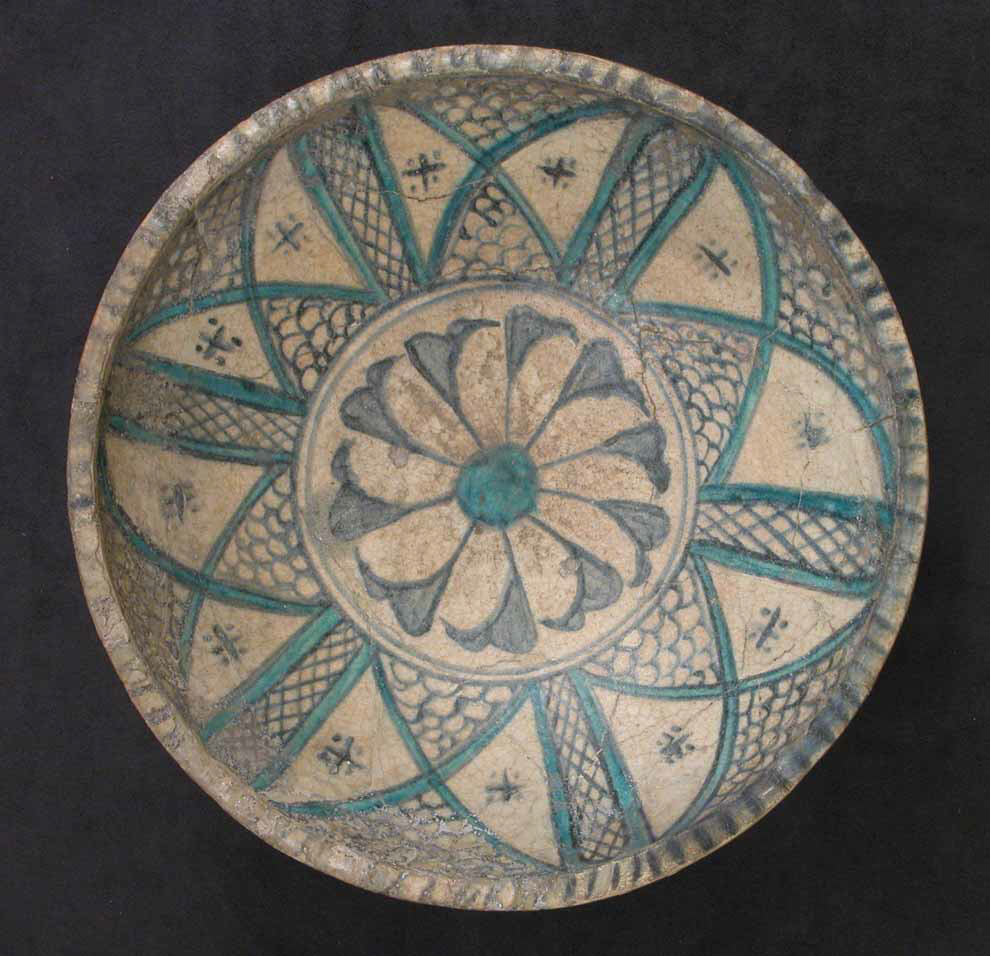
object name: bowl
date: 1201-1300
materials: earthenware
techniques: glazing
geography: syria